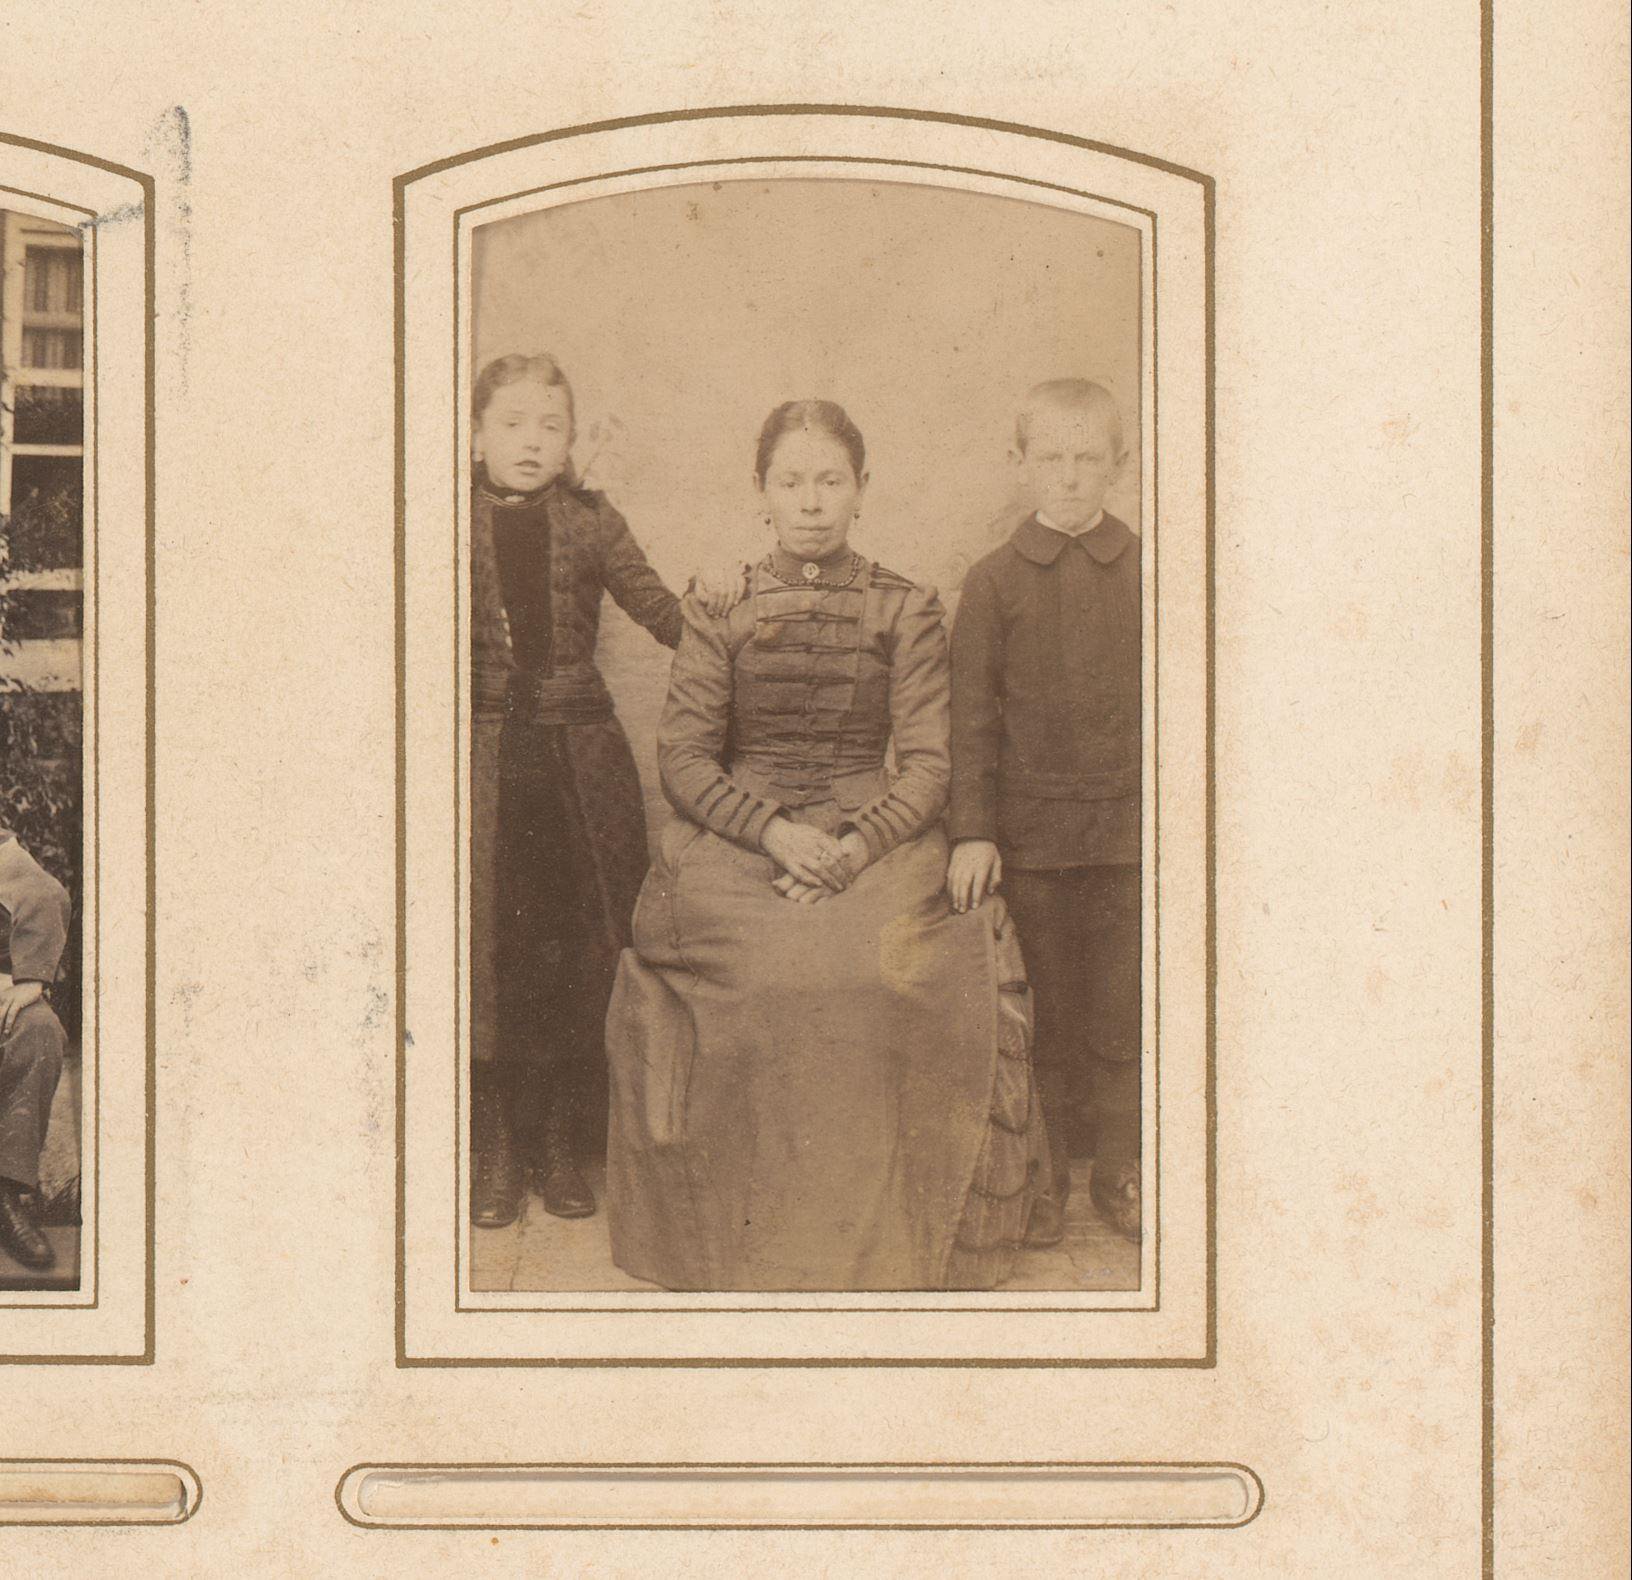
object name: carte de visite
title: Portret van een vrouw, een jongen en een meisje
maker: Anonymous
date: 1860-1875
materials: cardboard, paper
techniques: albumen print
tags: historical persons - bb - woman, mother and child(ren), woman and child(ren) (family group)